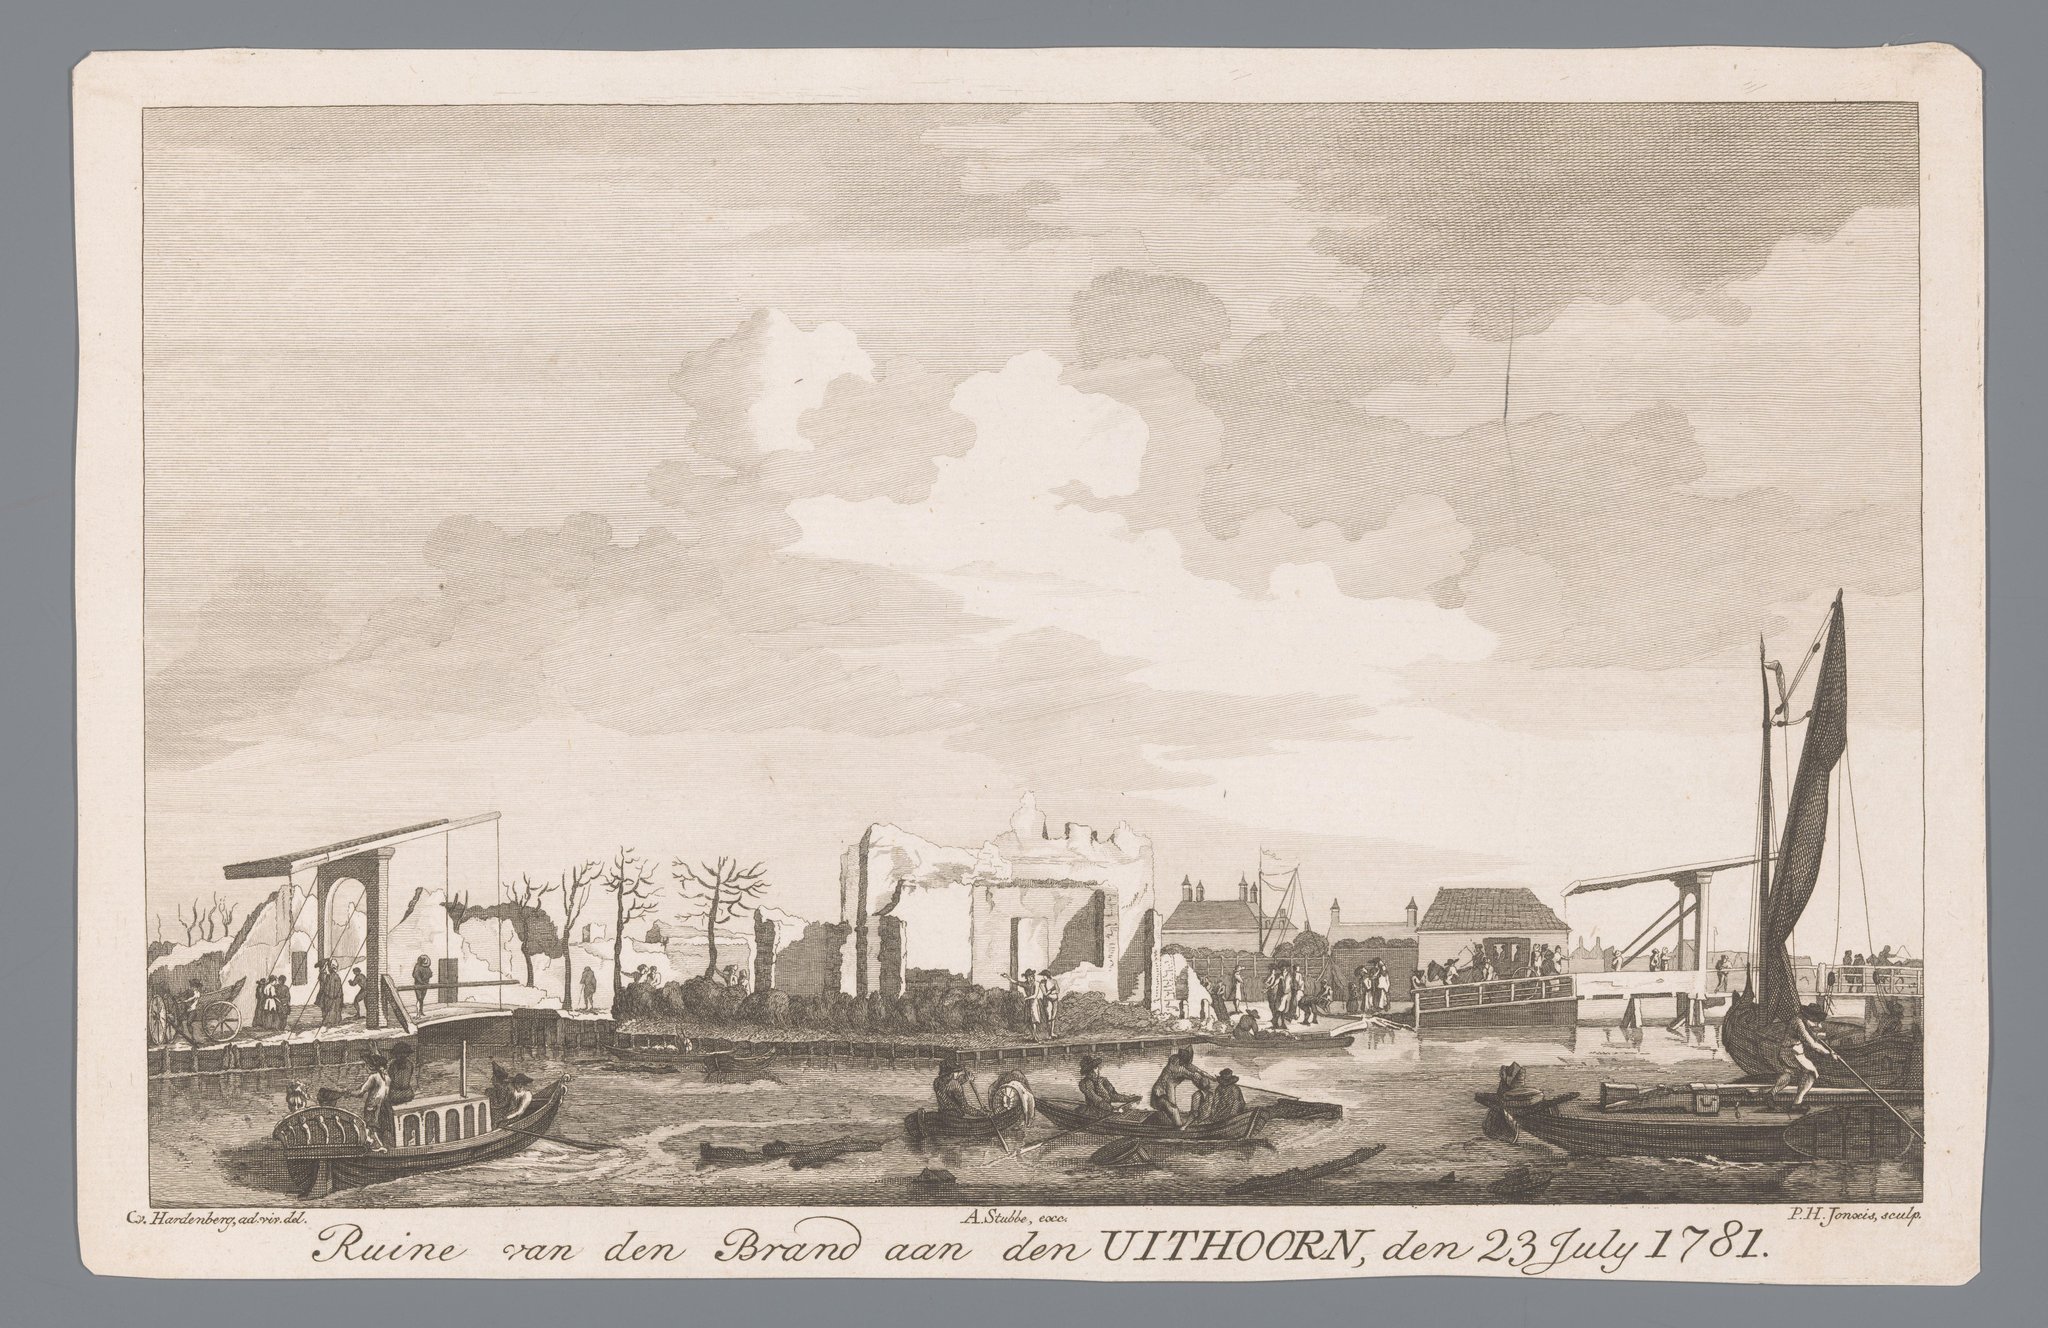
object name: print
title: Ruine van den brand aan den Uithoorn, den 23 july 1781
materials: paper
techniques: engraving, etching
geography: uithoorn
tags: on fire, ablaze, ruin of a dwelling, house, castle, etc.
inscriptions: collector's mark: Lugt 2233